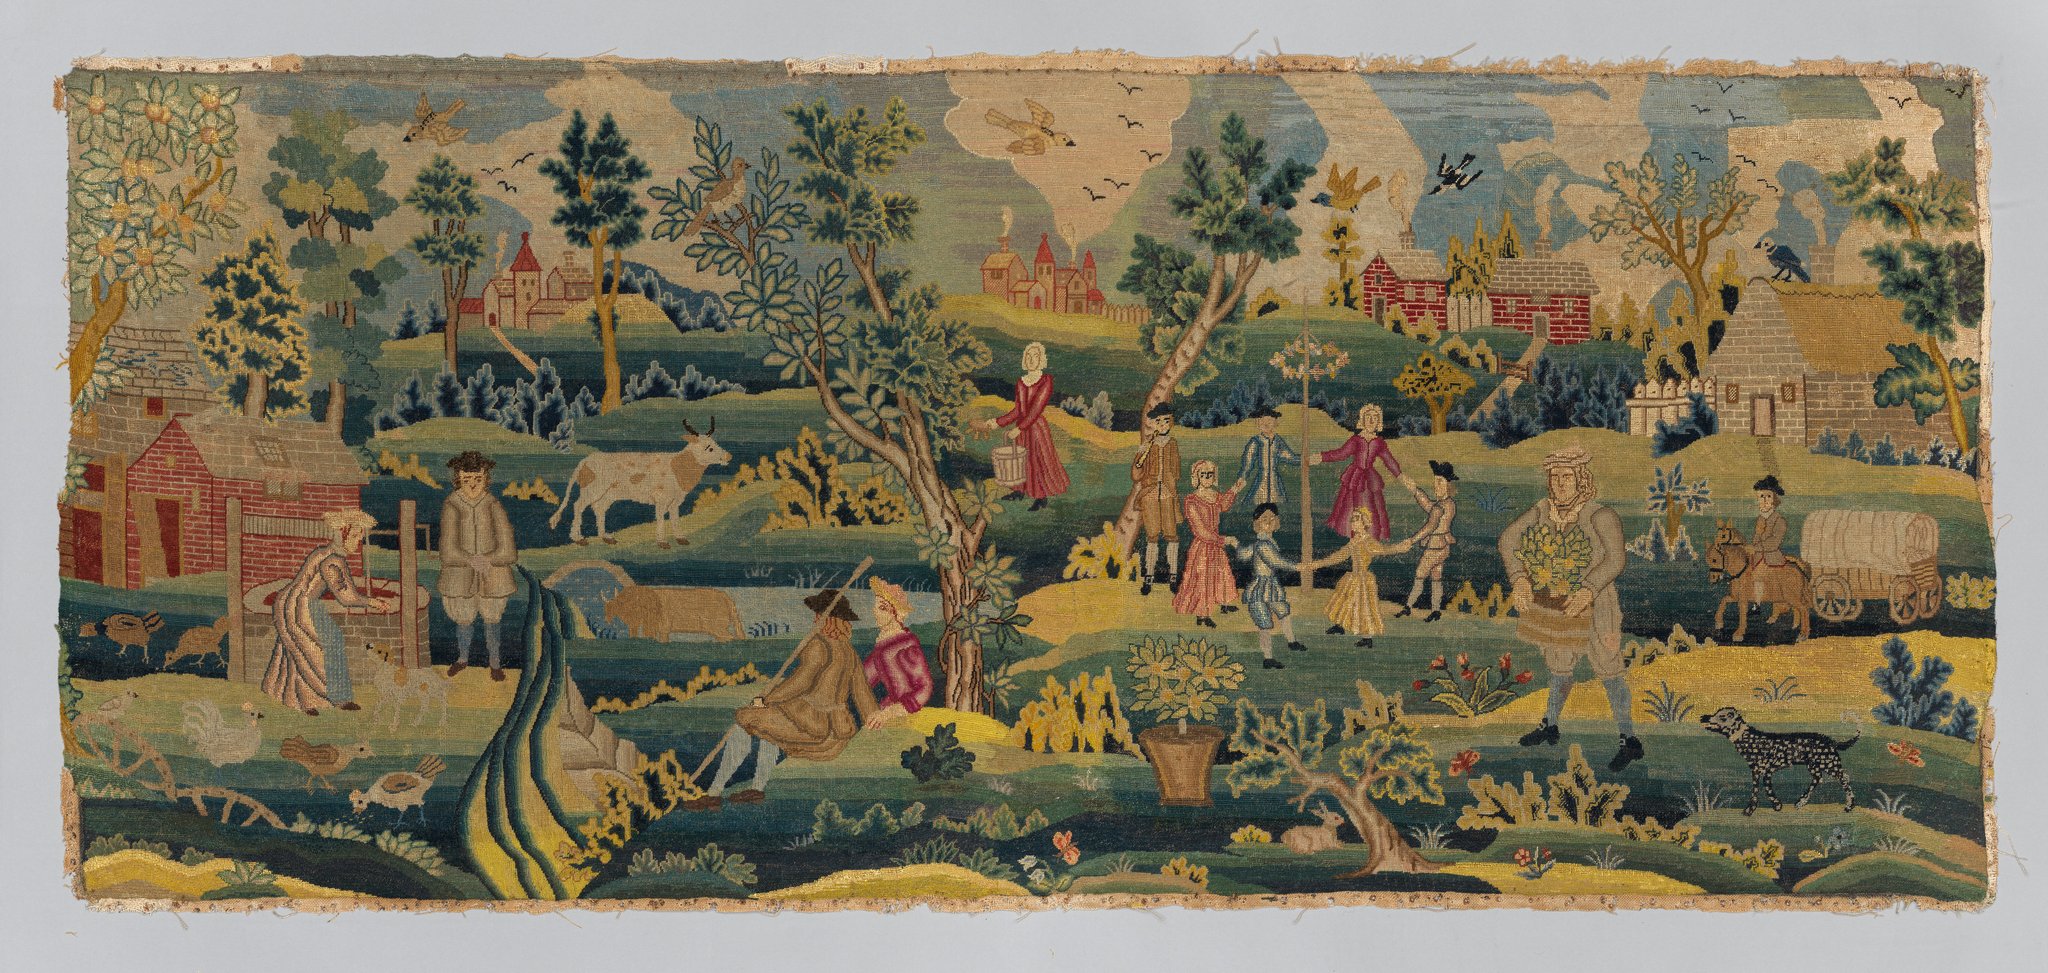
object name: embroidered picture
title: Needlework Picture with Maypole Scene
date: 1700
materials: canvas, silk, wool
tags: boys,girls,men,dancing,cows,dogs,horses